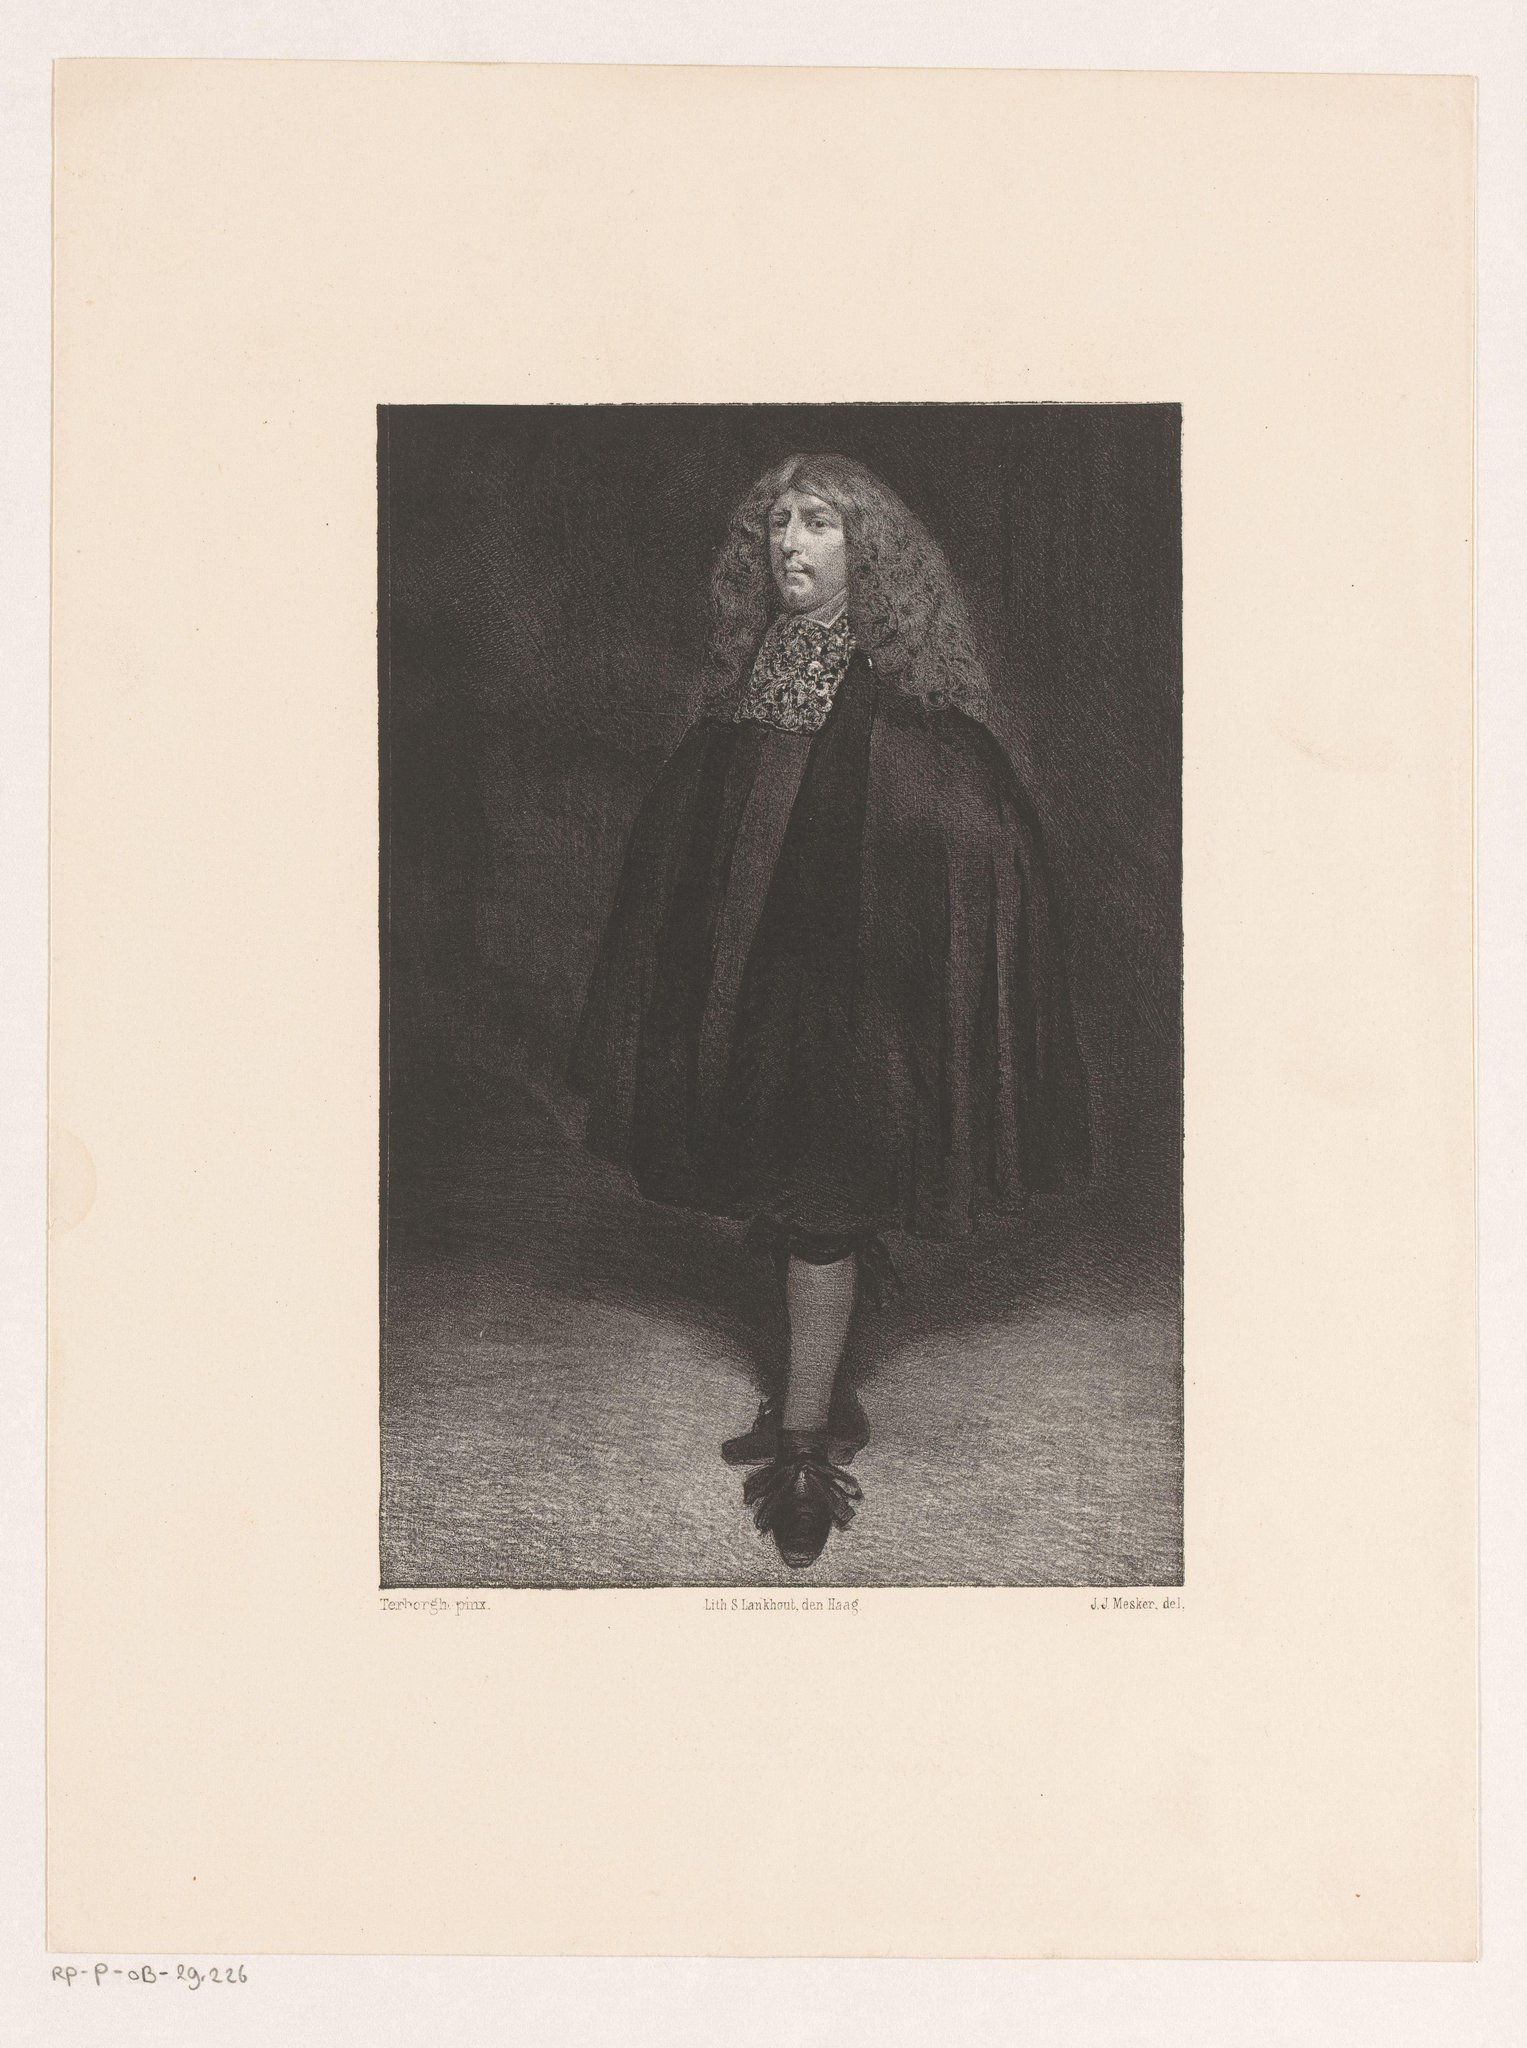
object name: print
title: Portret van Gerard ter Borch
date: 1875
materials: paper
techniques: lithograph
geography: the hague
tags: deventer, painter, draughtsman, gerard ter borch (ii), cape, portrait, self-portrait of artist, historical persons (+ full length portrait)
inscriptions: collector's mark: Lugt 2228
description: Prent waarschijnlijk uit: Kunstkronijk, nr. 37, 1875.